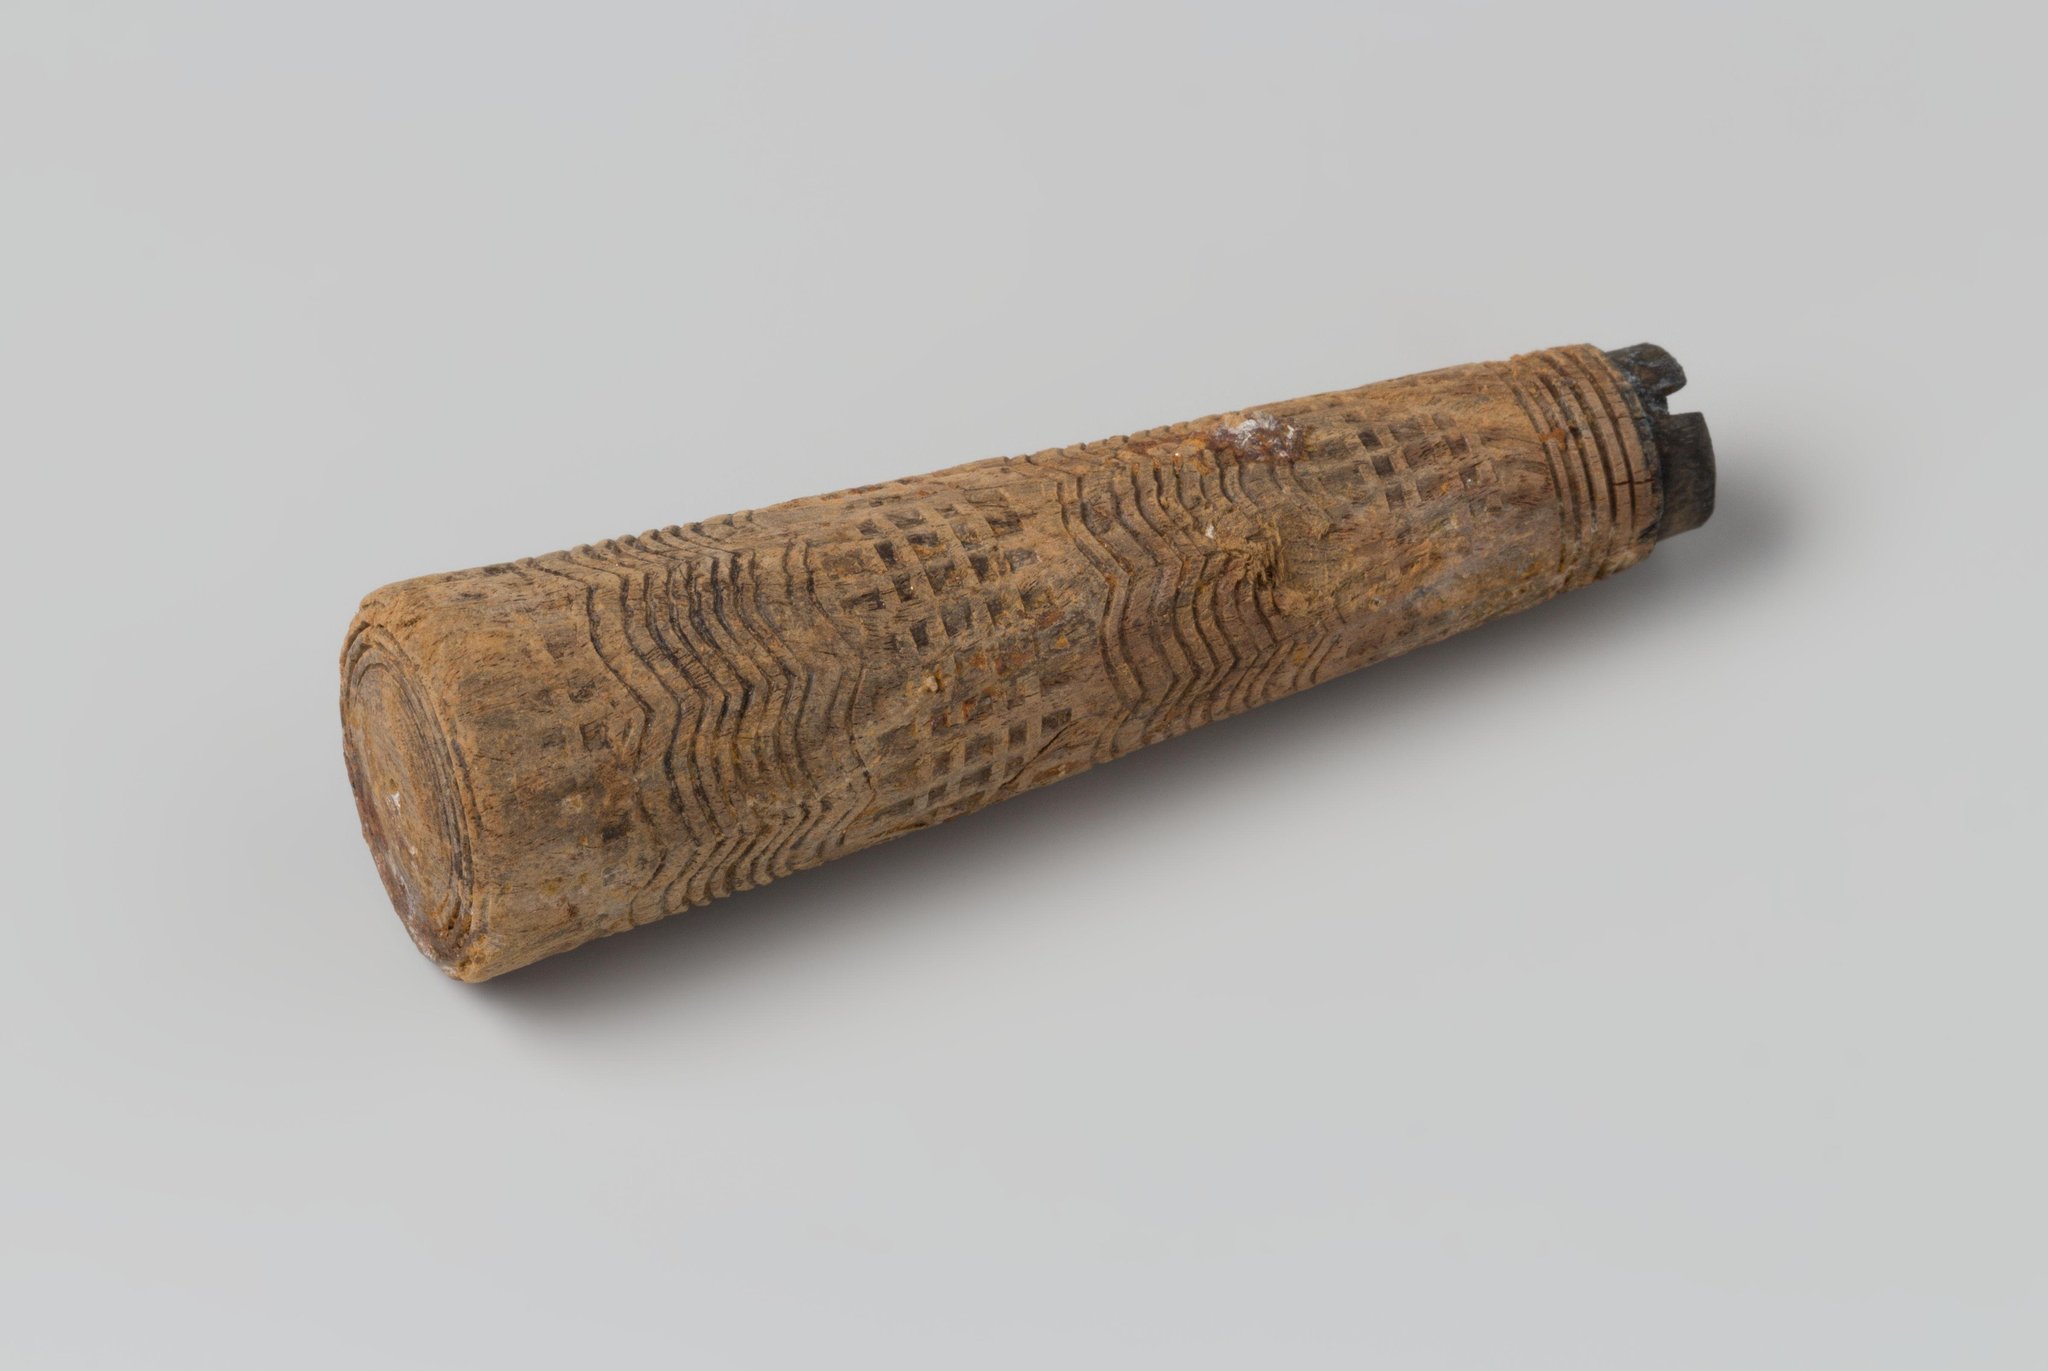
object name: knife handle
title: Messenheft uit het wrak van de Oost-Indiëvaarder Hollandia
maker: Anonymous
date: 1700-1743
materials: copper, wood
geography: netherlands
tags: verenigde oostindische compagnie, hollandia (schip), annet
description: Knife, handle, cylindrical: tapering; id. NG 1979-403H.